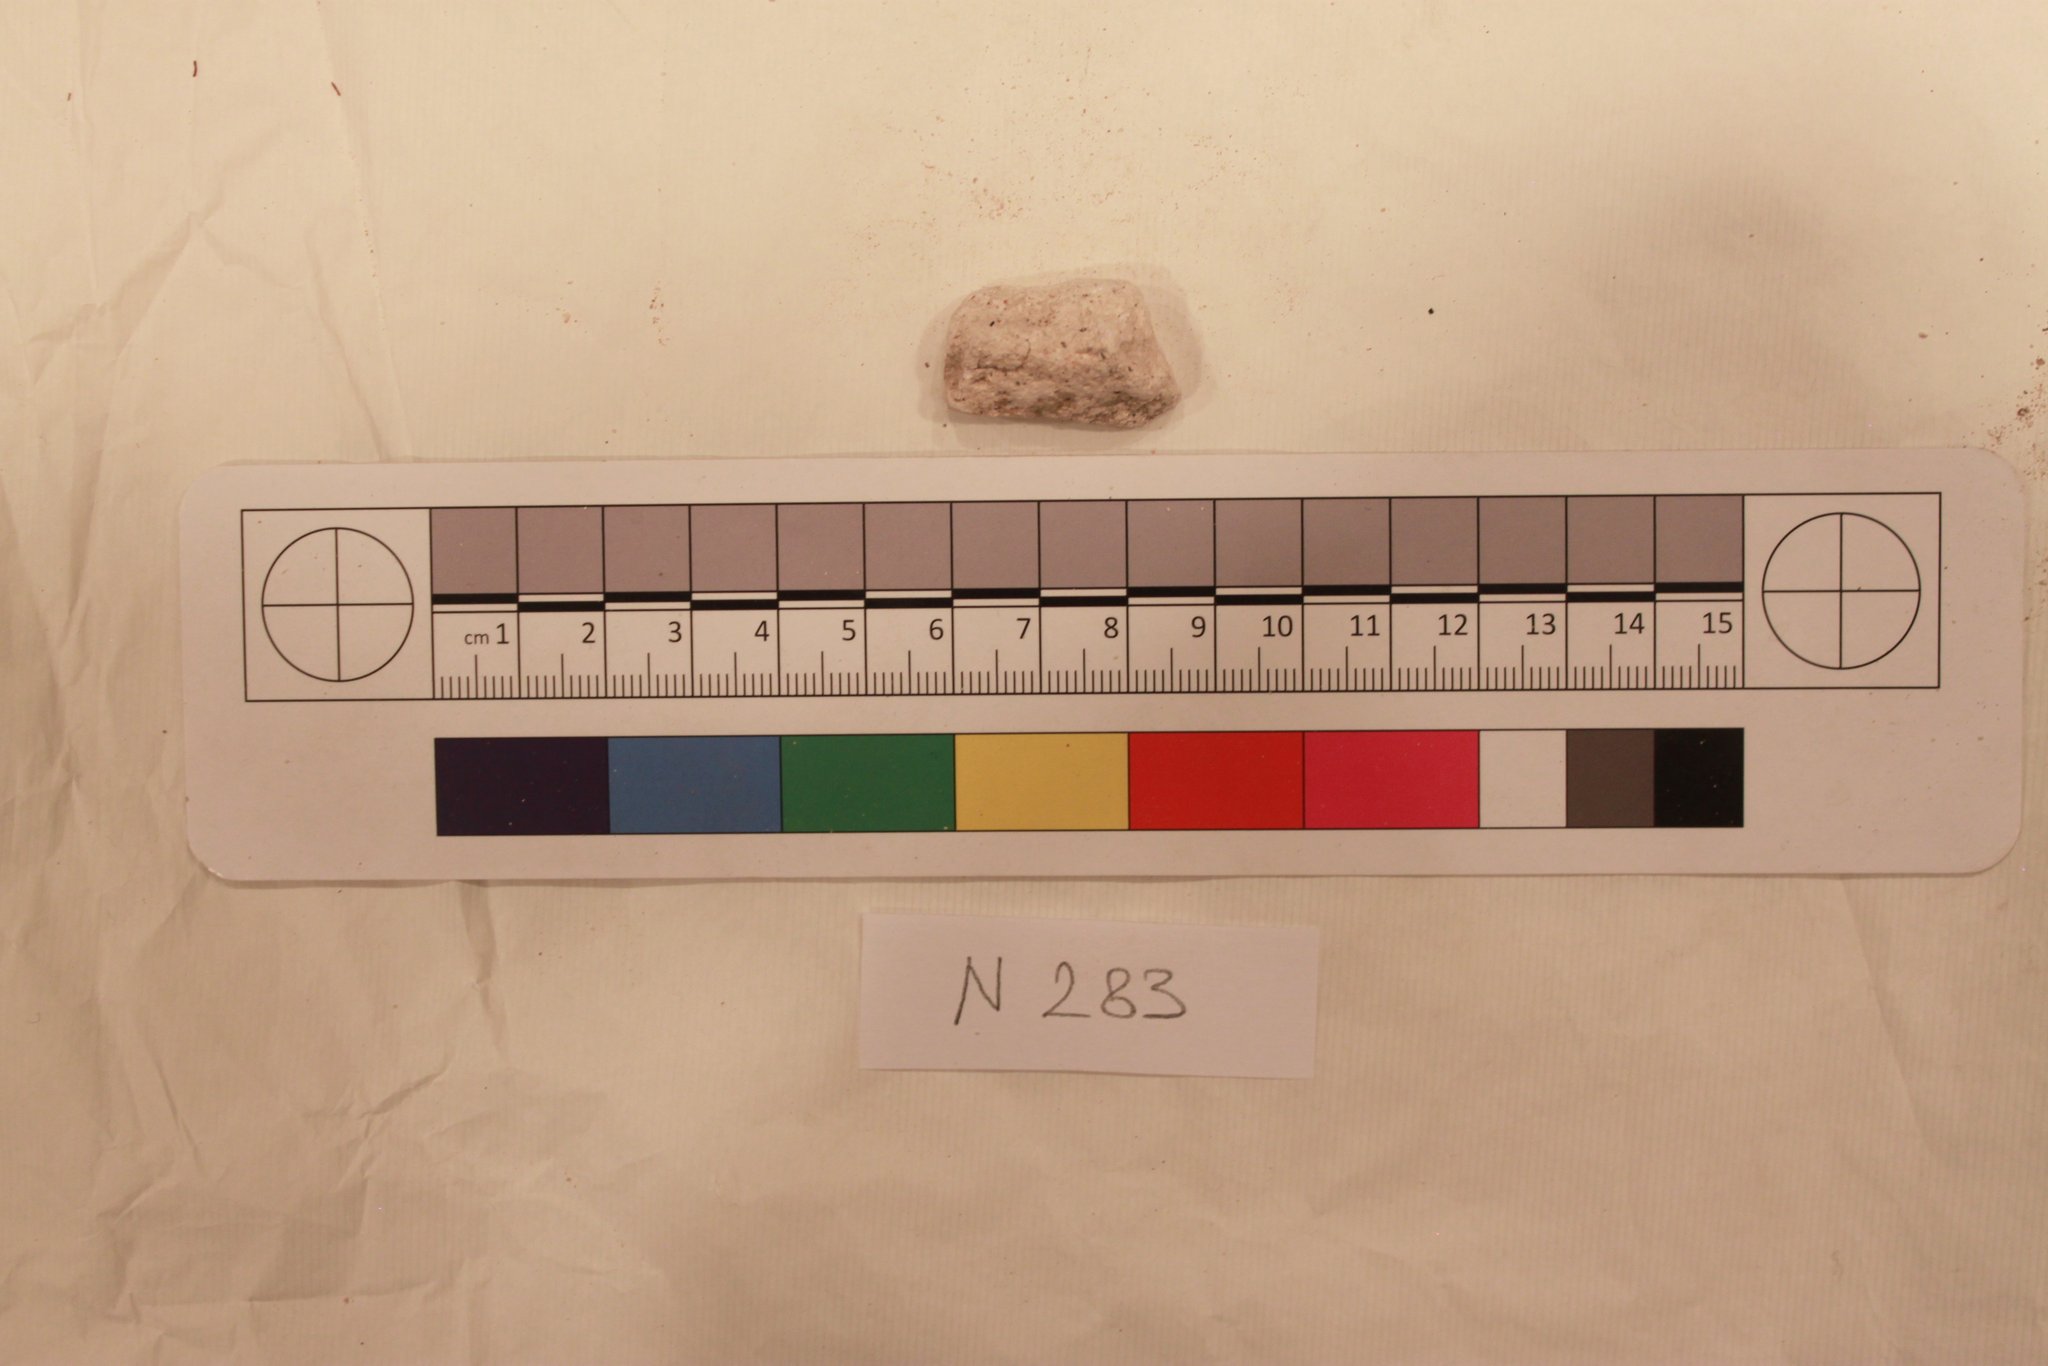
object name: fragment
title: Stucco Fragment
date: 701-1200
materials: plaster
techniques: carving, painting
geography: iran